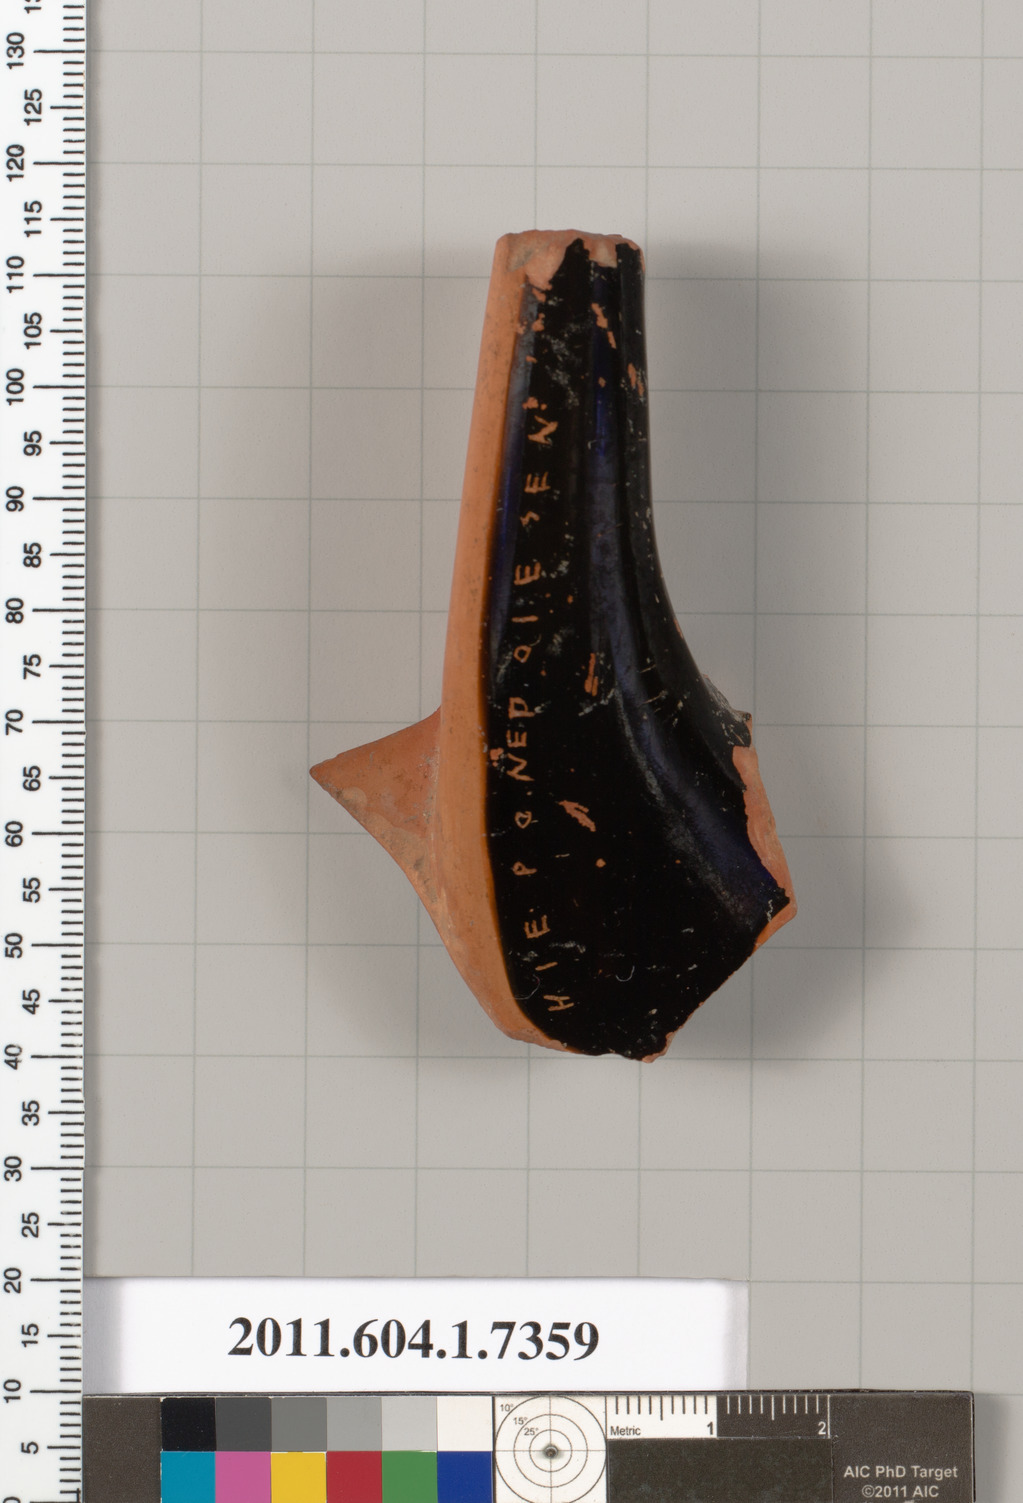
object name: kylix fragment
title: Terracotta fragment of a kylix (drinking cup)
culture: greek, attic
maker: makron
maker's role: artist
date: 500-480 BCE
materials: terracotta